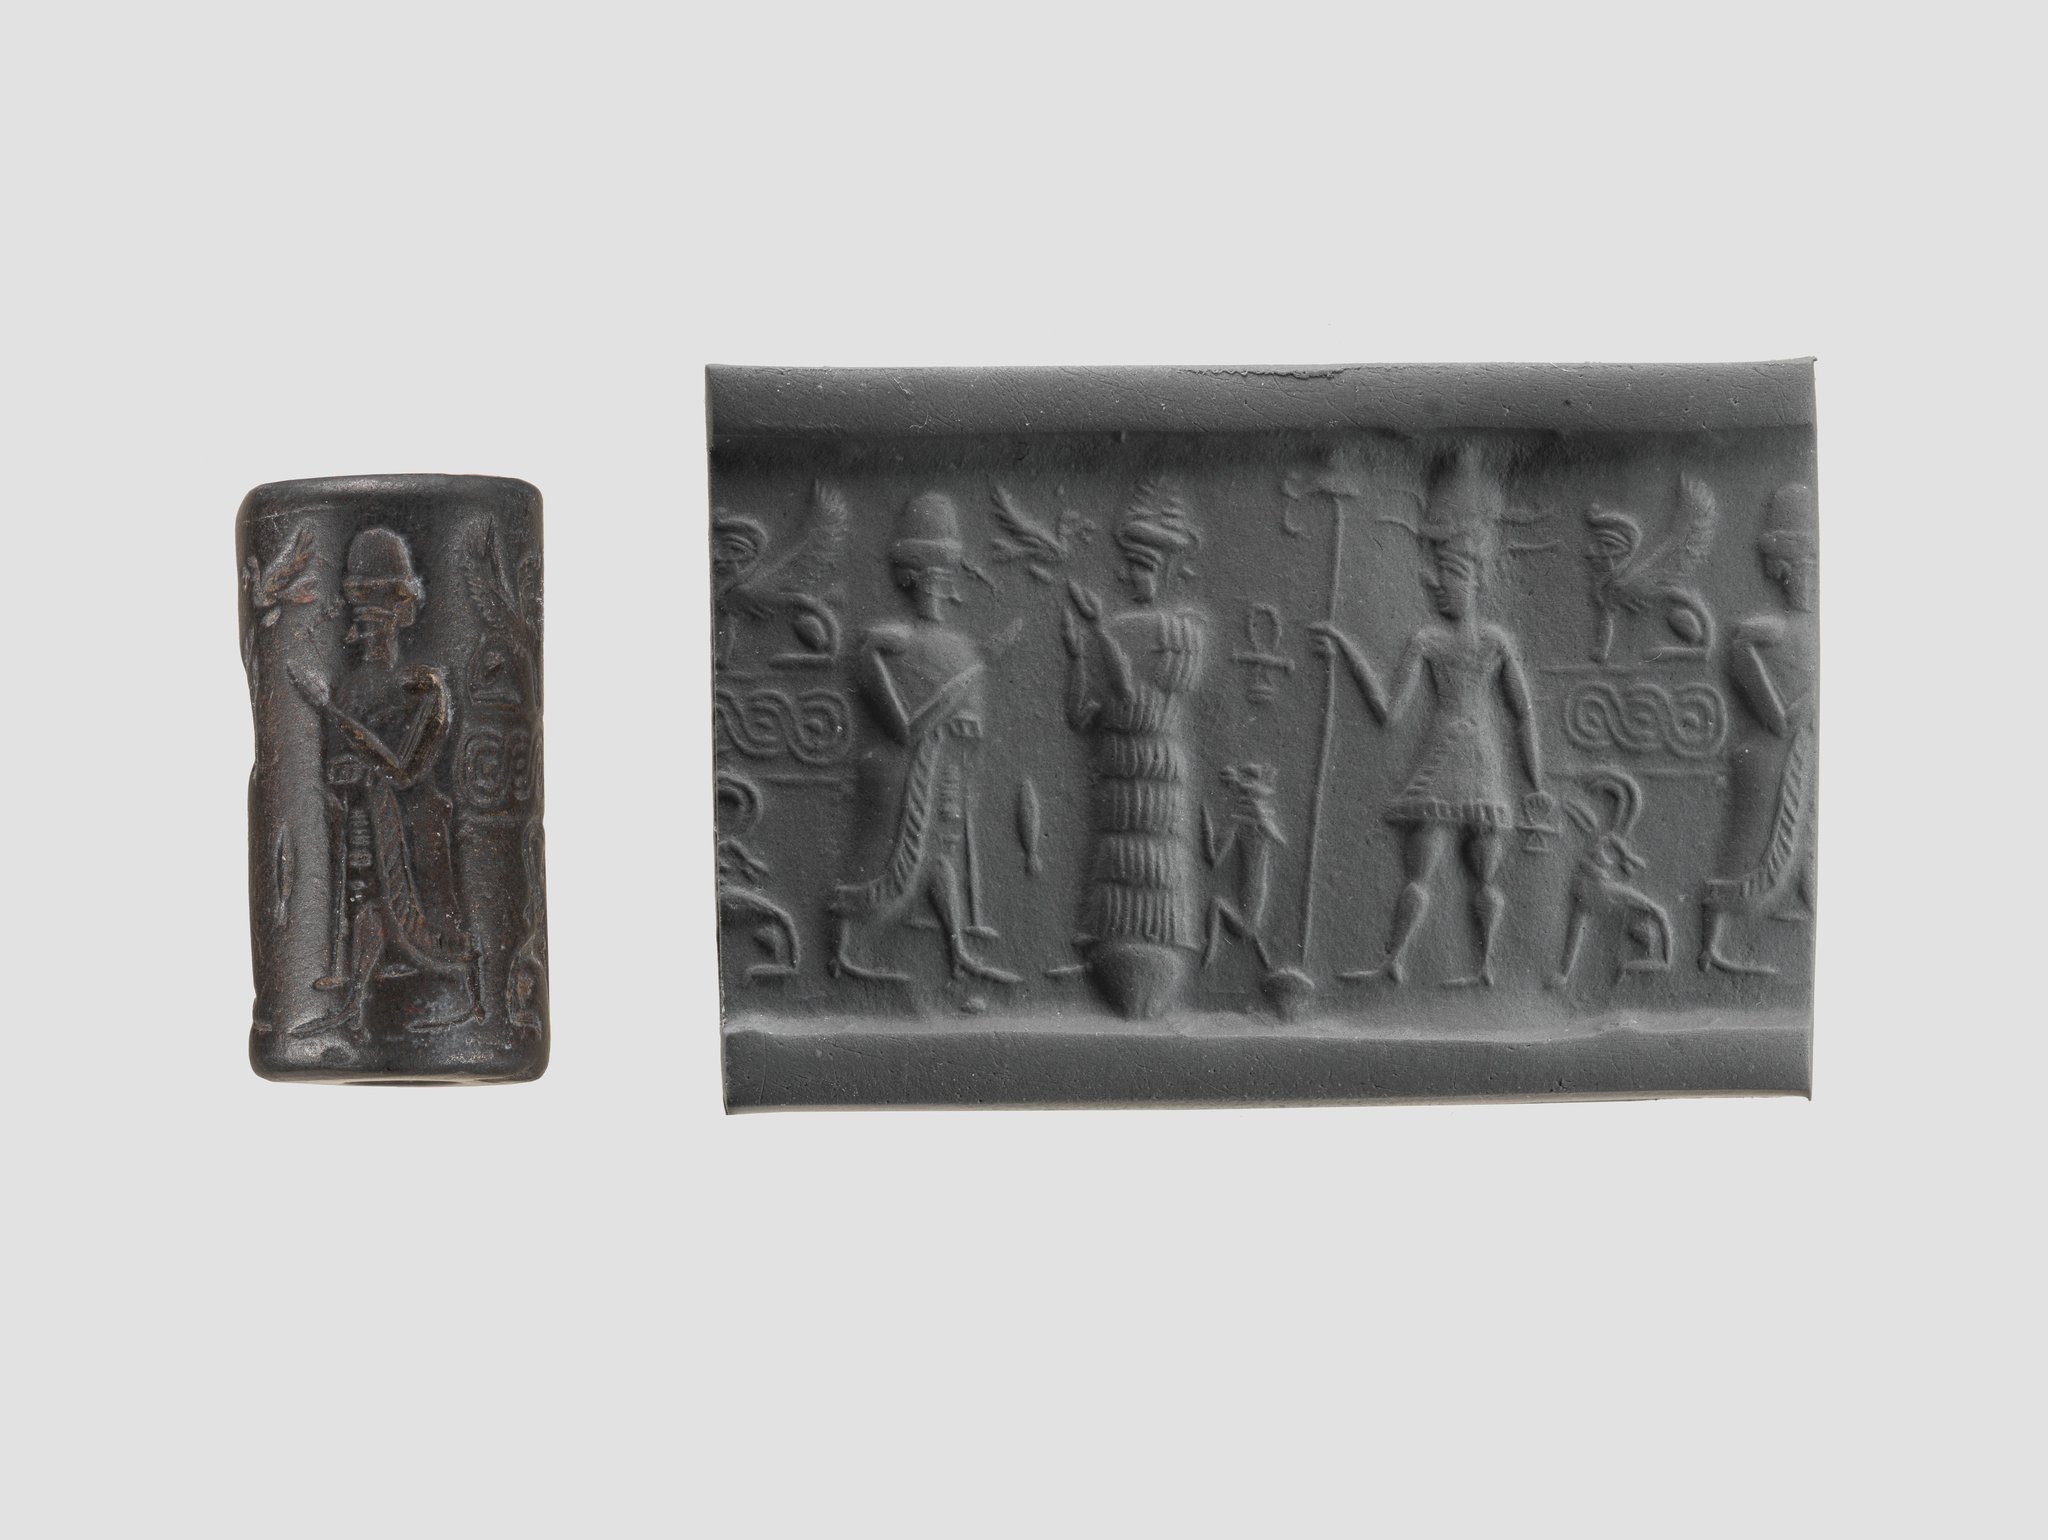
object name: cylinder seal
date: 1820-1730 BCE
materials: mineral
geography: syria